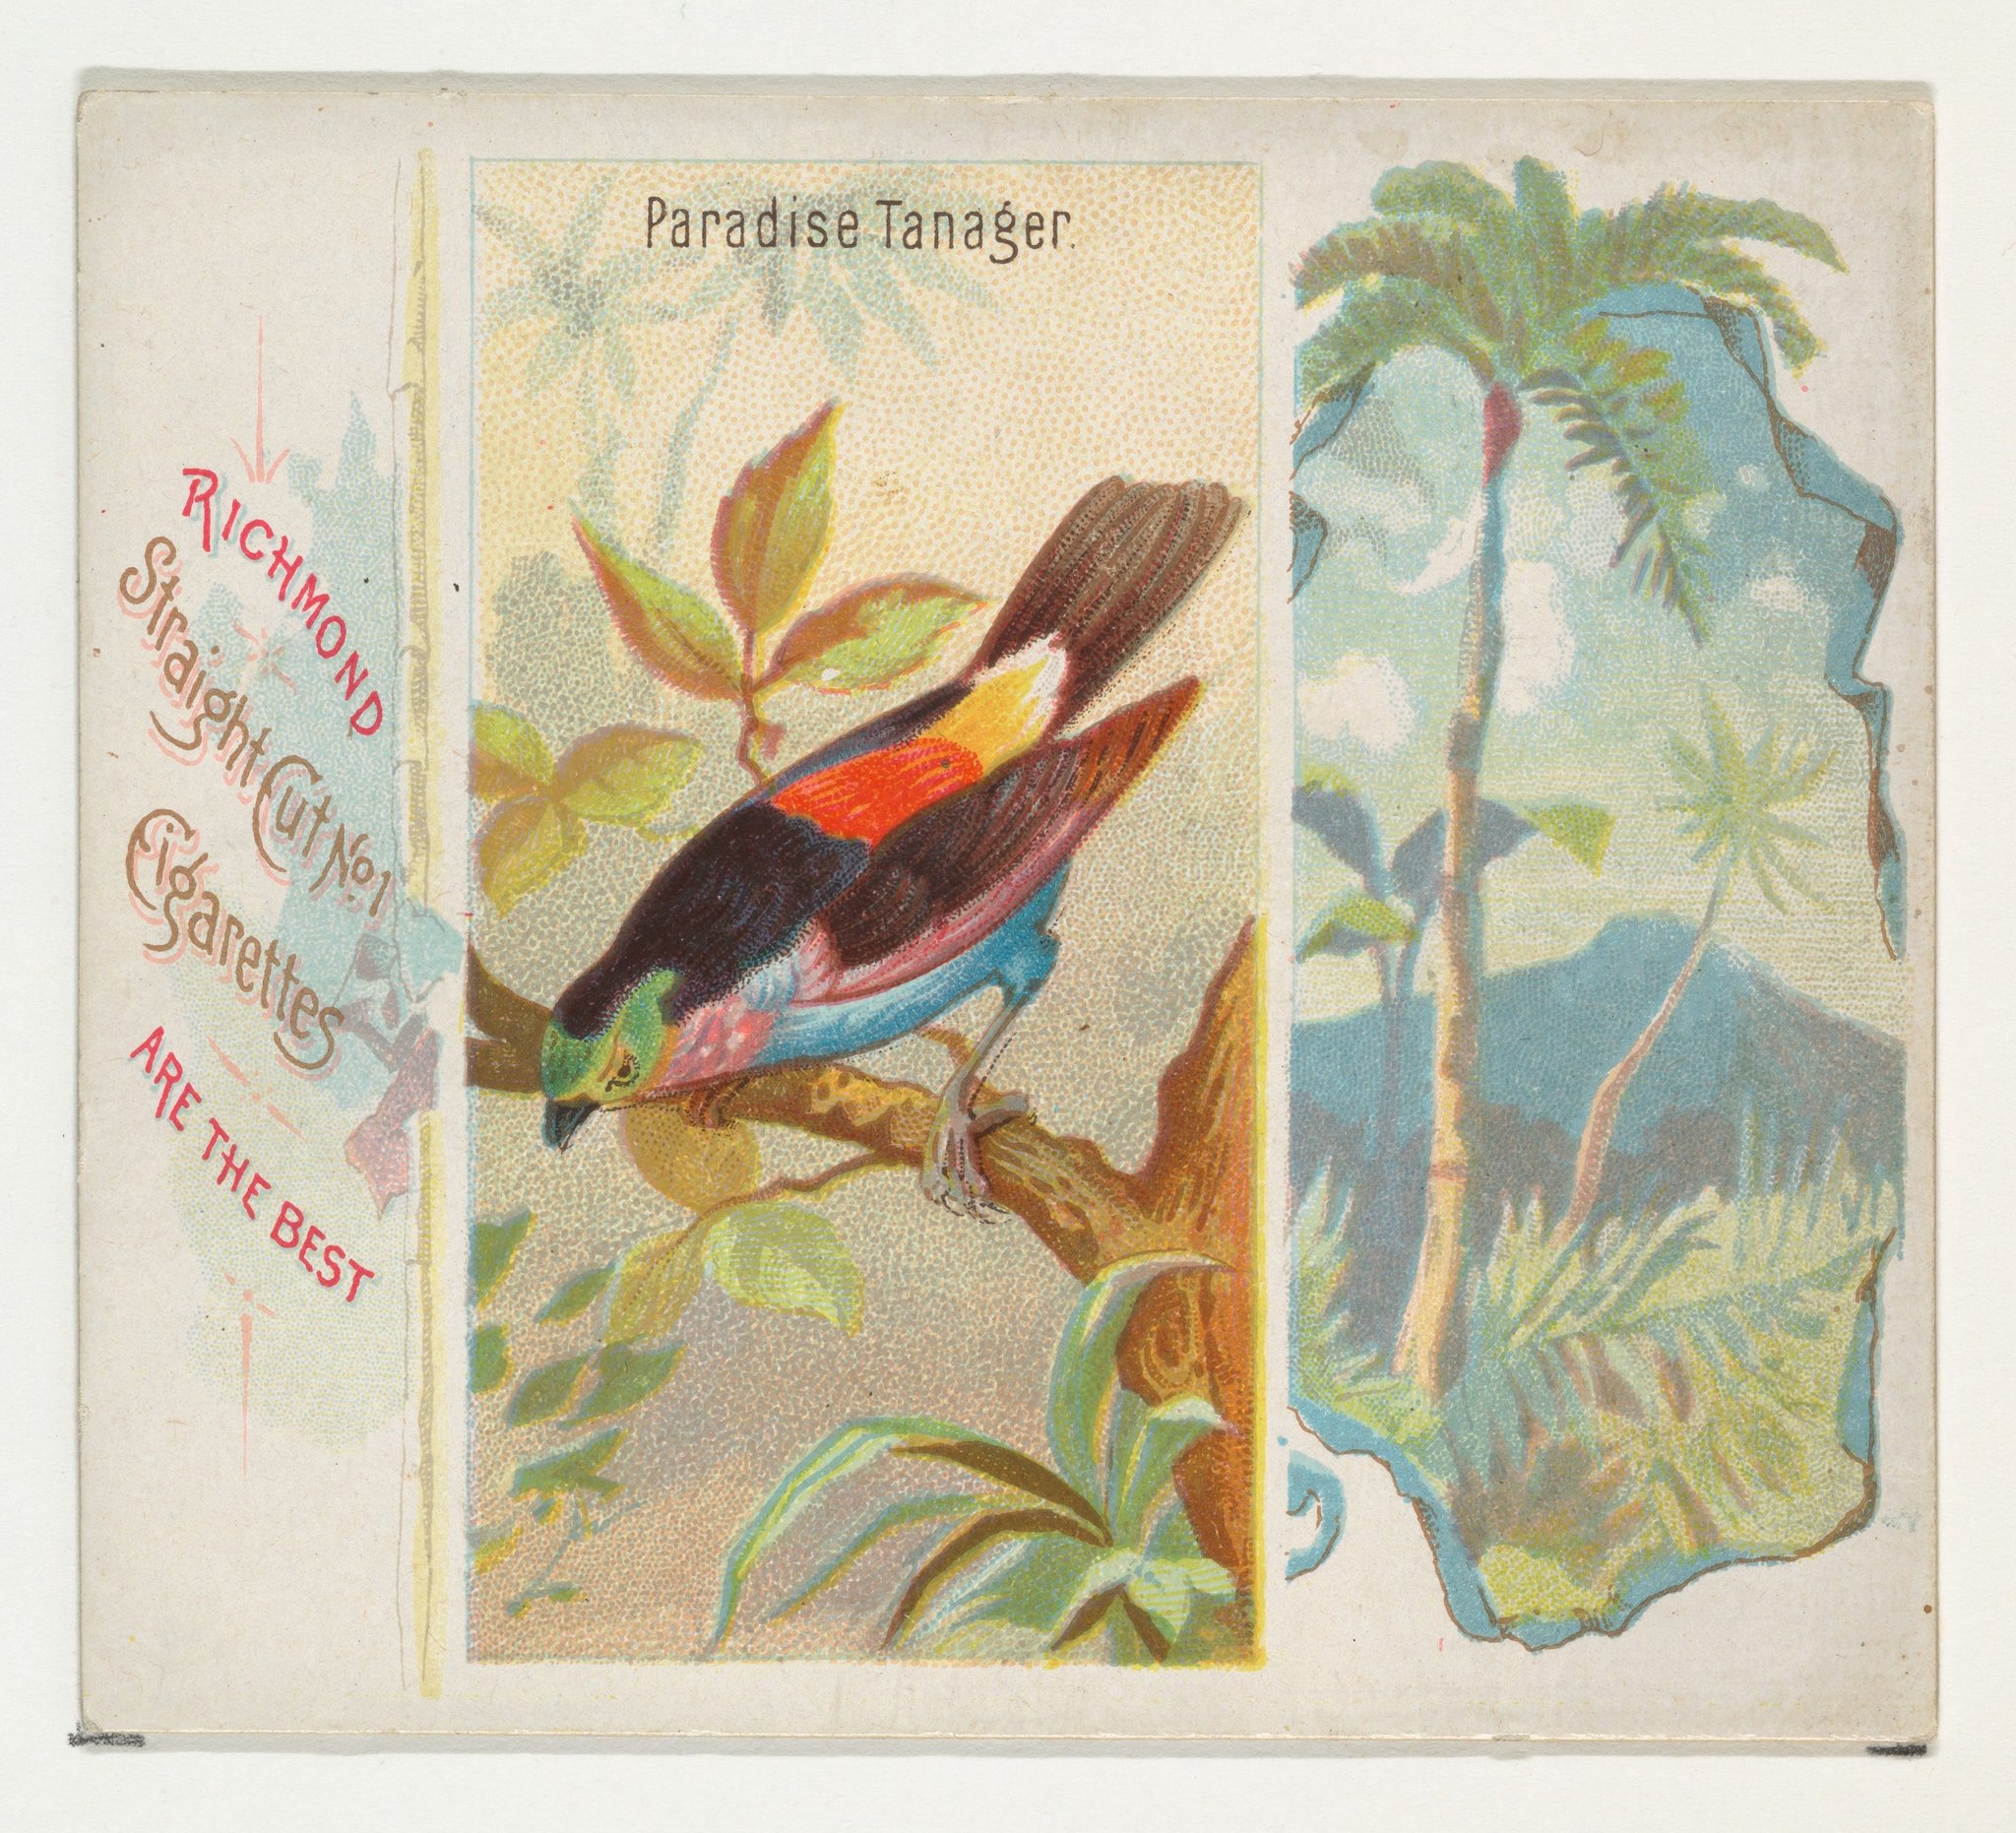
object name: print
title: Paradise Tanager, from Birds of the Tropics series (N38) for Allen & Ginter Cigarettes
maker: allen & ginter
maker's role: publisher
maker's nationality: american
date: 1889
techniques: color lithograph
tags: birds